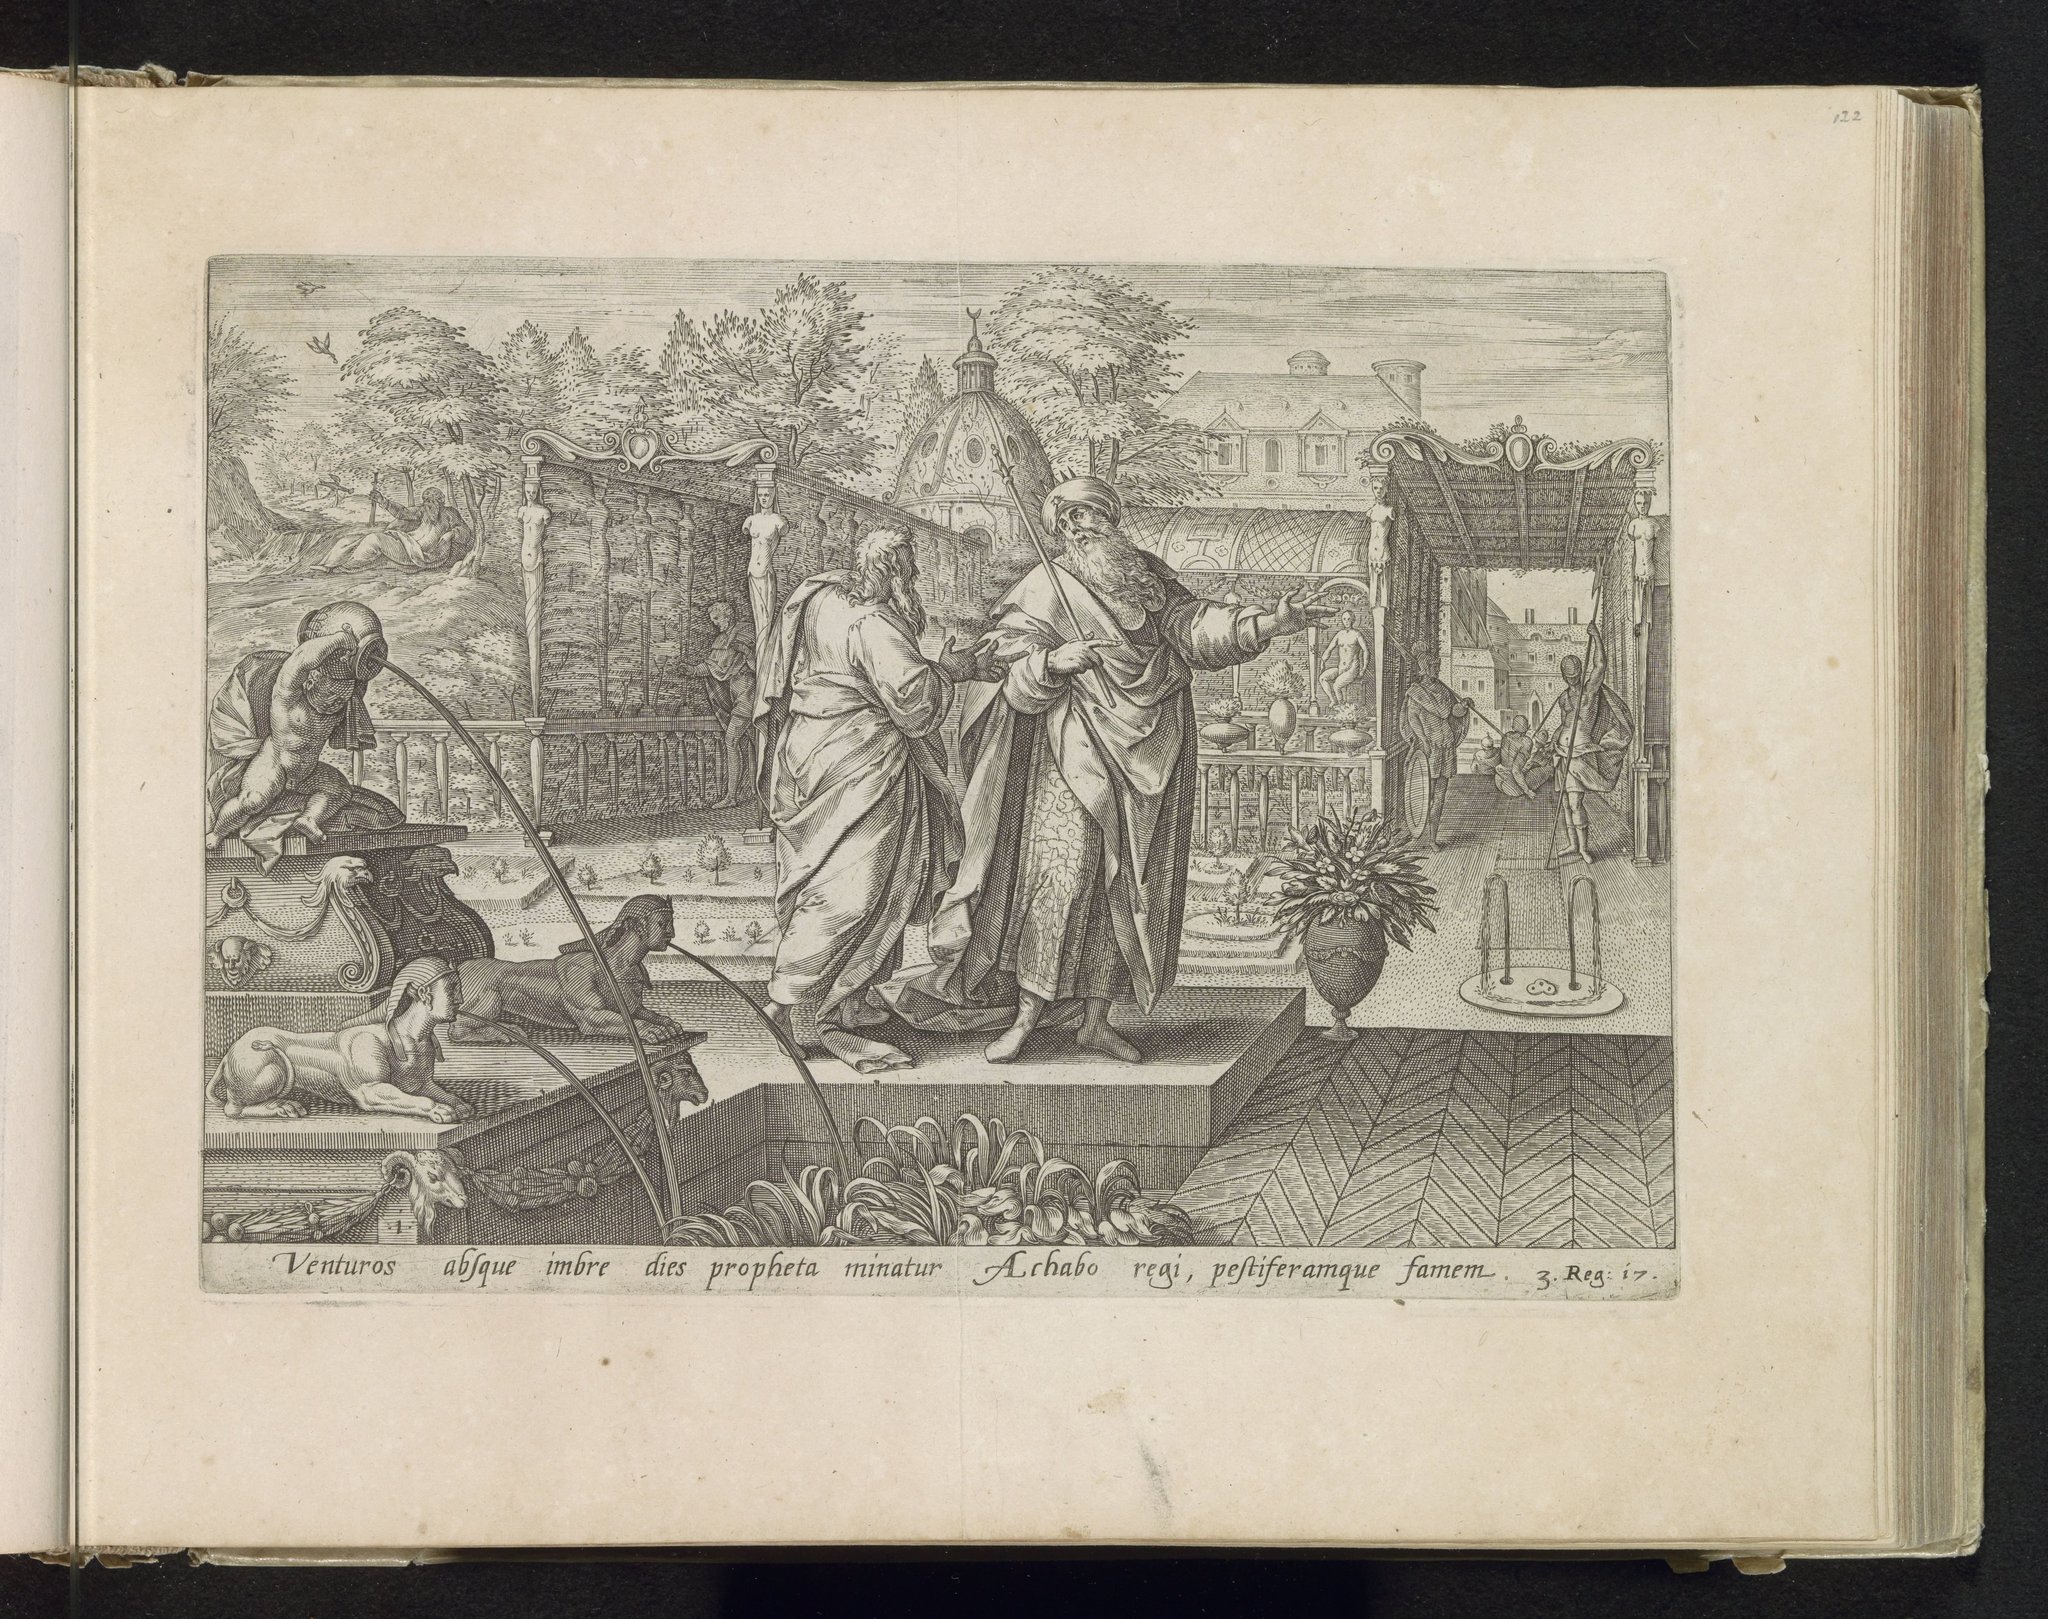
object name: album leaf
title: Elia voorspelt koning Achab dat er droogte zal komen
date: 1585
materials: paper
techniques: engraving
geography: antwerp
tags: elijah announces to king ahab that god will bring a long drought in the land to avenge the apostasy of israel, elijah fed by the raven(s): while the prophet is living by the brook, ravens bring him food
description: Elia voorspelt aan koning Achab dat er een aantal jaar geen dauw of regen zal vallen. Links op de achtergrond zit Elia bij de beek Kirit waar raven hem van voedsel voorzien. Onder de voorstelling een verwijzing in het Latijn naar de Bijbeltekst in 1 Kon. 17. Deze prent maakt deel uit van een album.